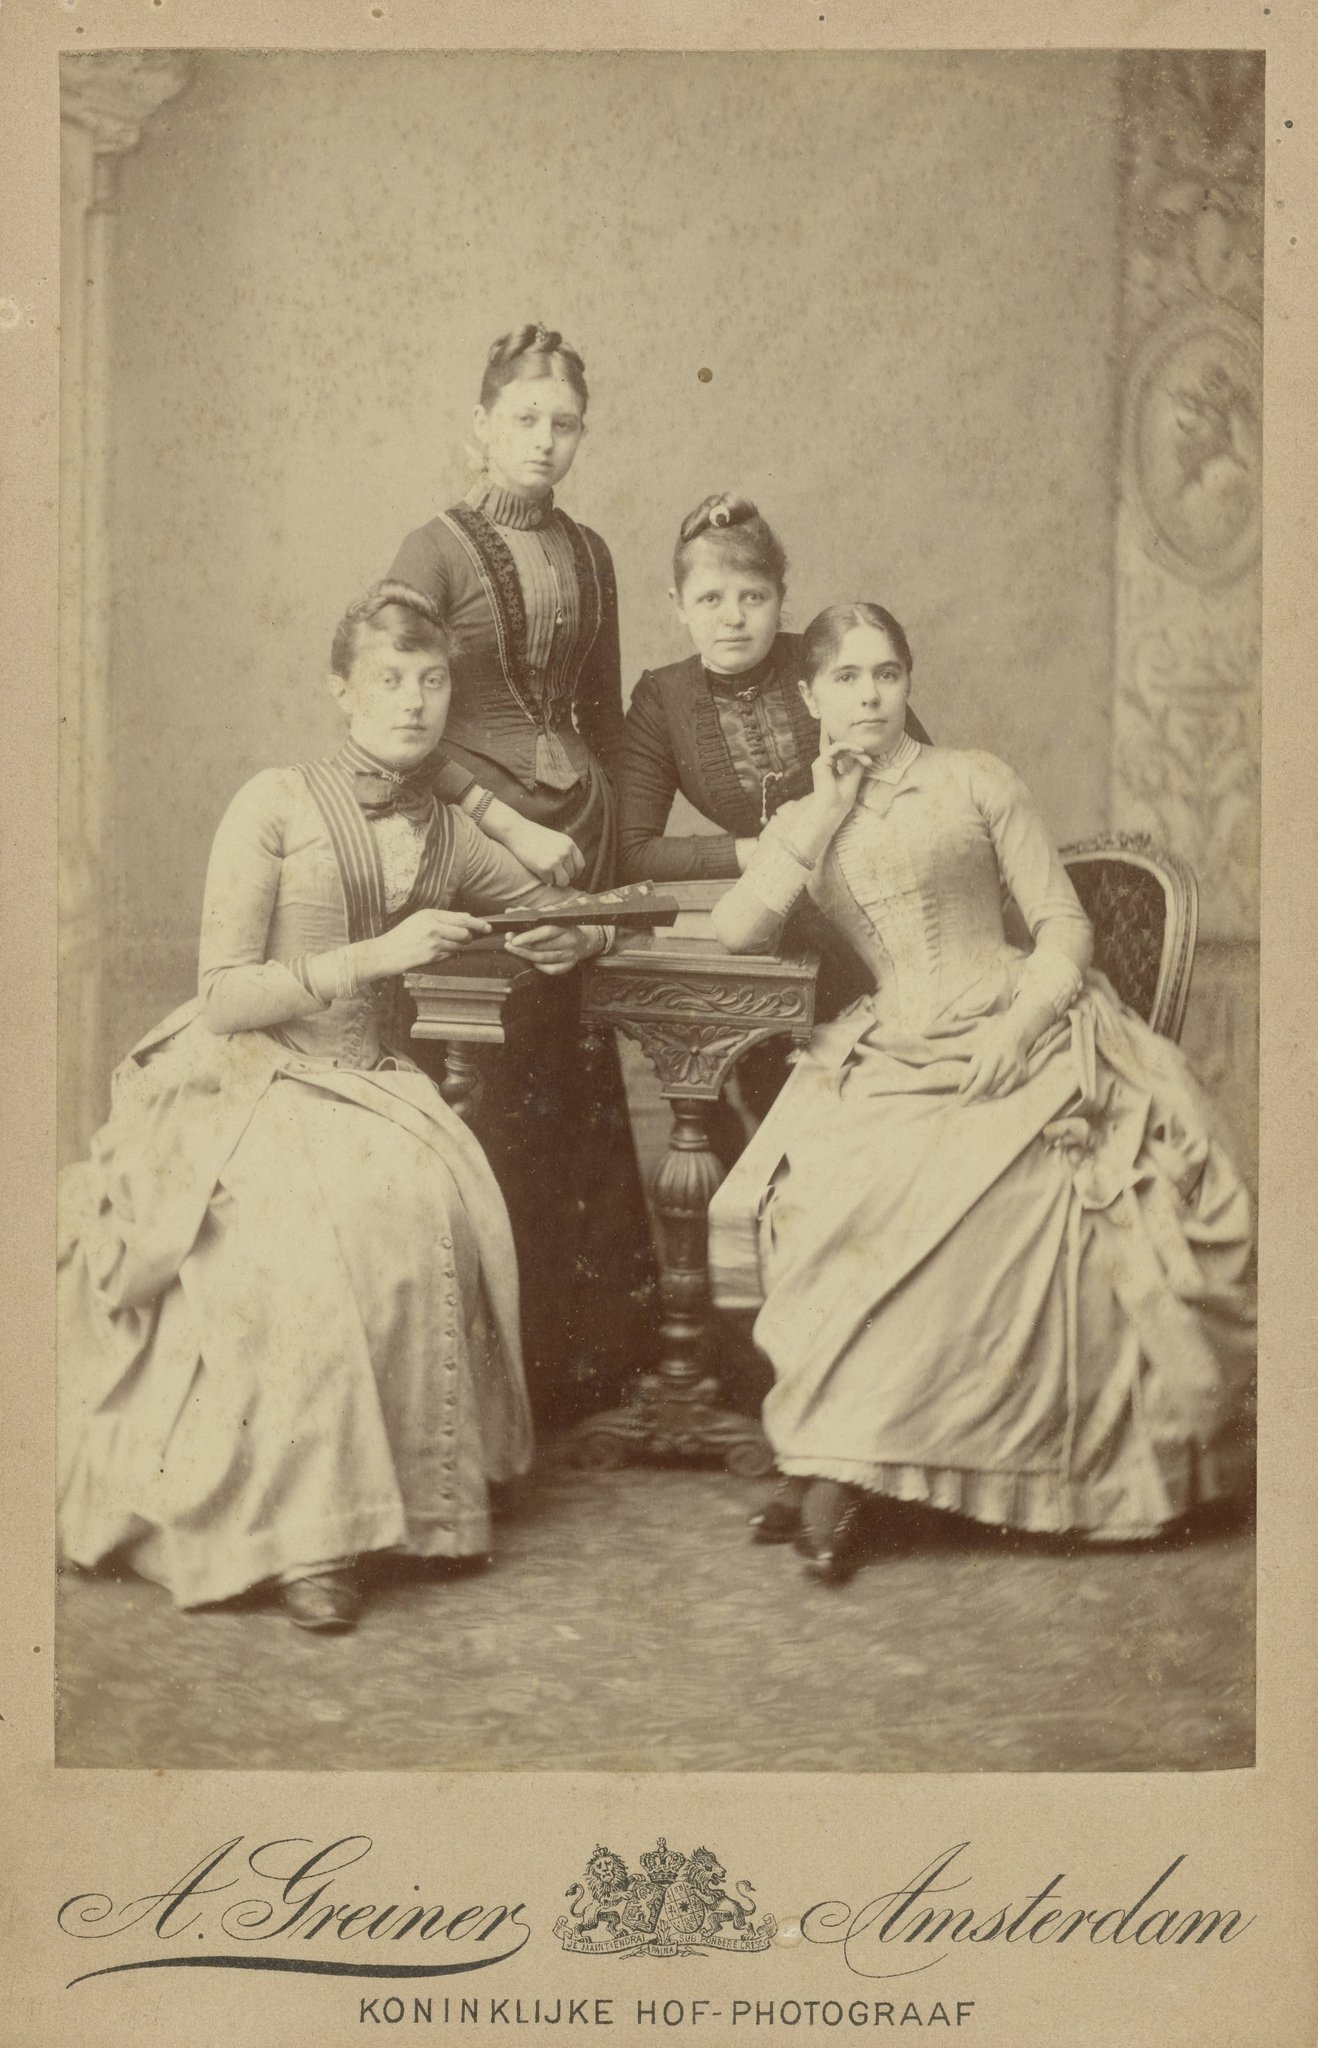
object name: photograph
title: Studiogroepsportret met Charlotte Doorman, A. Avis, L. Funke en I. Lindenhout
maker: albert greiner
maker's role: fotograaf, fotostudio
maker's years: 1833-1890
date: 1885-1900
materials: paper, photographic support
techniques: albumen print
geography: amsterdam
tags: amsterdam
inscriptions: name: ‘Albert Greiner, kon. ned. hof-photograaf Amsterdam’, inscription: ‘Charlotte A. Doorman geh. Matthes, A. Avis, geh. met Zurhuller, V: I Lindenhout, L. Franke’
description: personen op de foto zijn vermoedleijk Charlotte A. Doorman geh. Matthes, A. Avis, geh. met Zurhuller, V: I Lindenhout, L. Franke